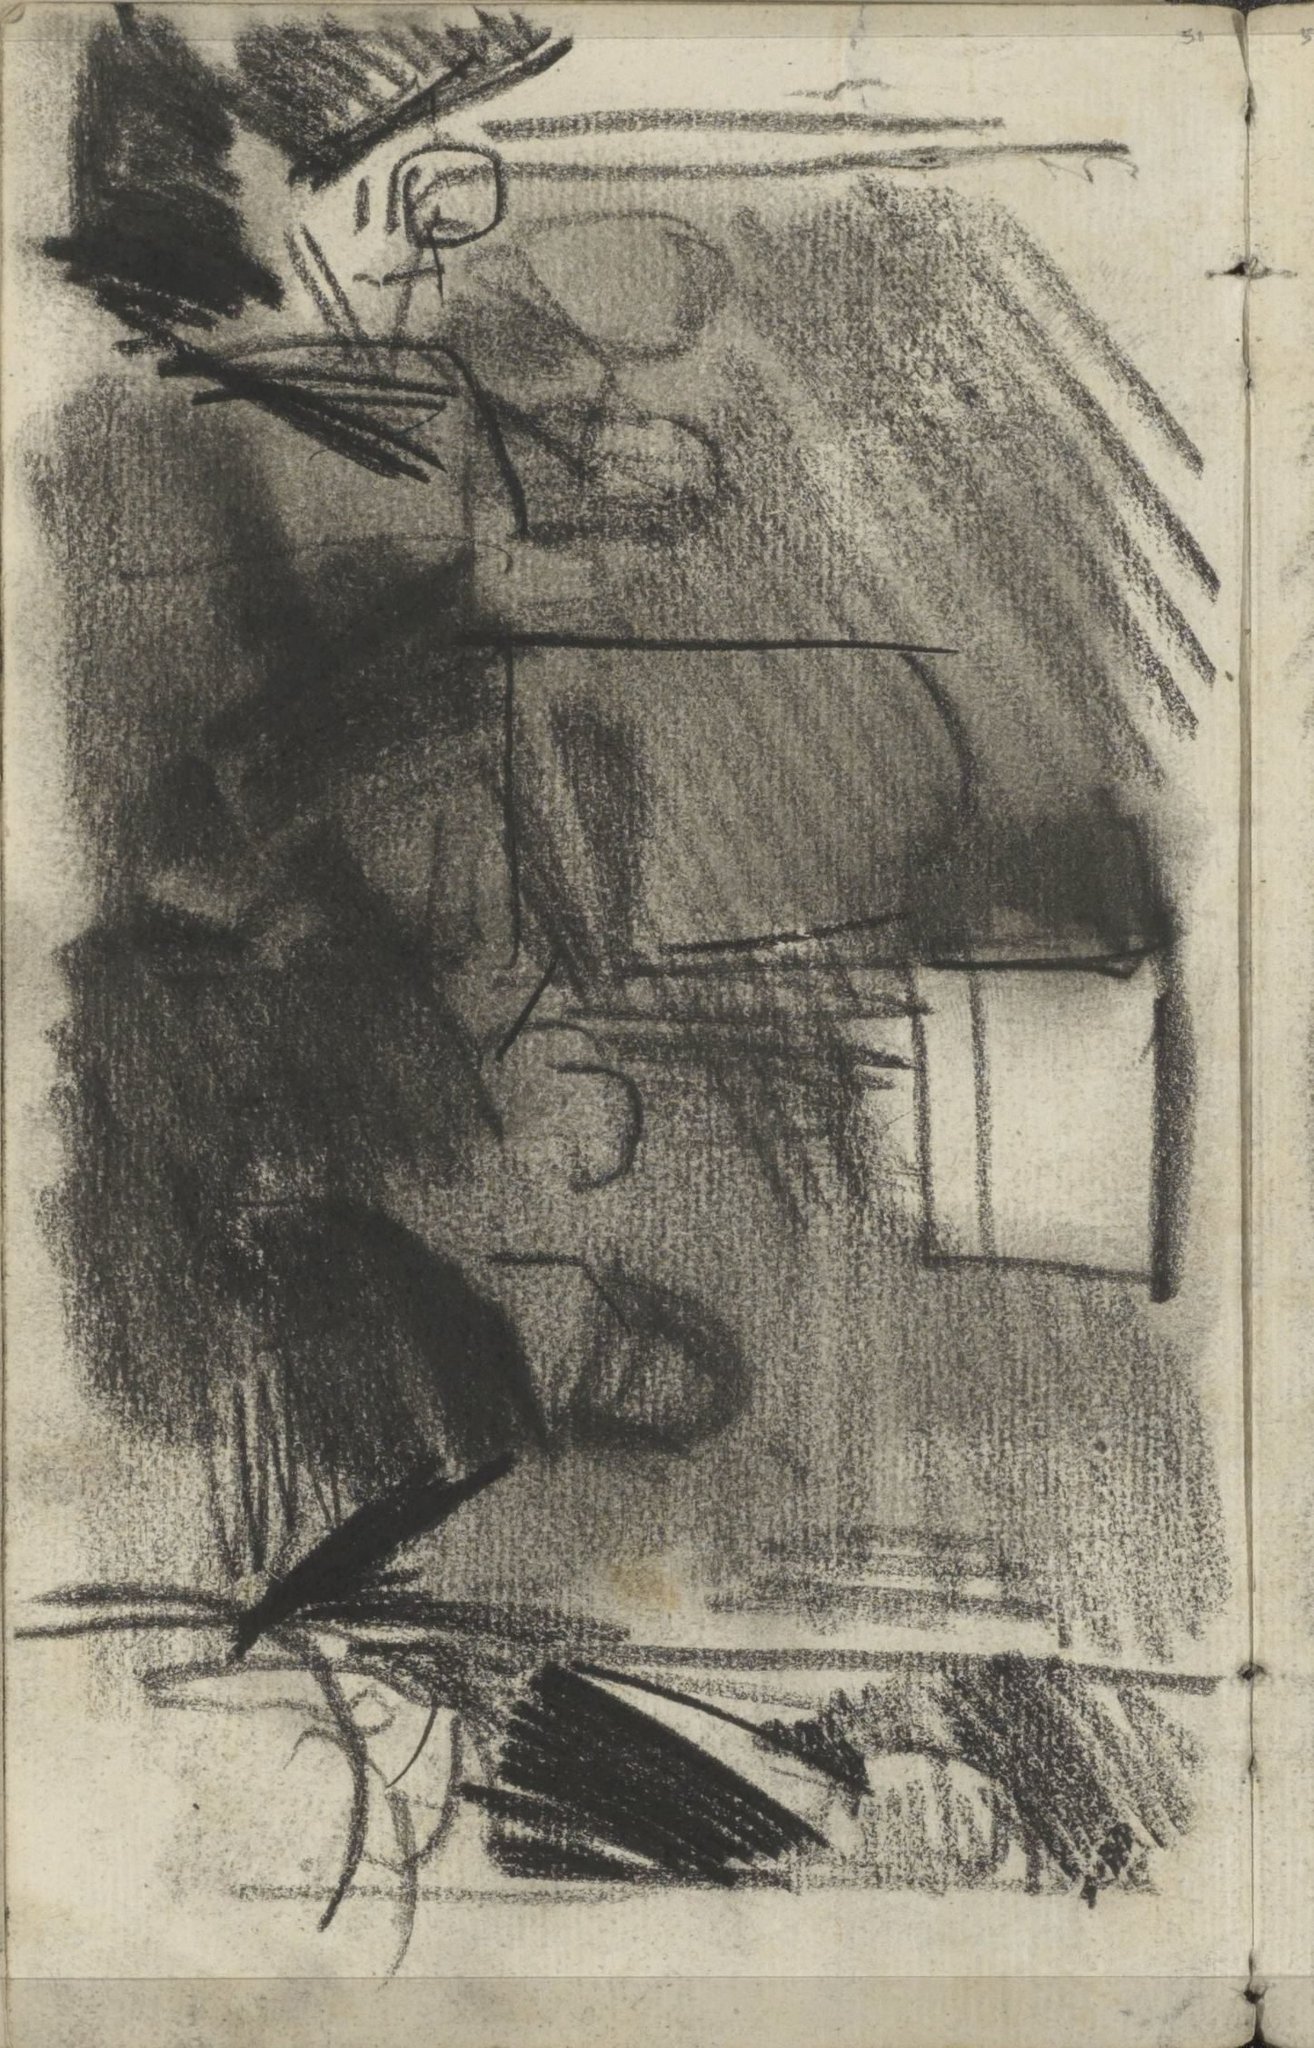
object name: sketchbook leaf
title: Zittende figuren in een interieur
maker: george hendrik breitner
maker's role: draughtsman, painter, print maker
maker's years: 1857-1923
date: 1884-1886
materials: chalk, paper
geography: the hague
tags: sitting figure, adult man, interior of the house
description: Pagina 51 uit een schetsboek met 29 bladen.